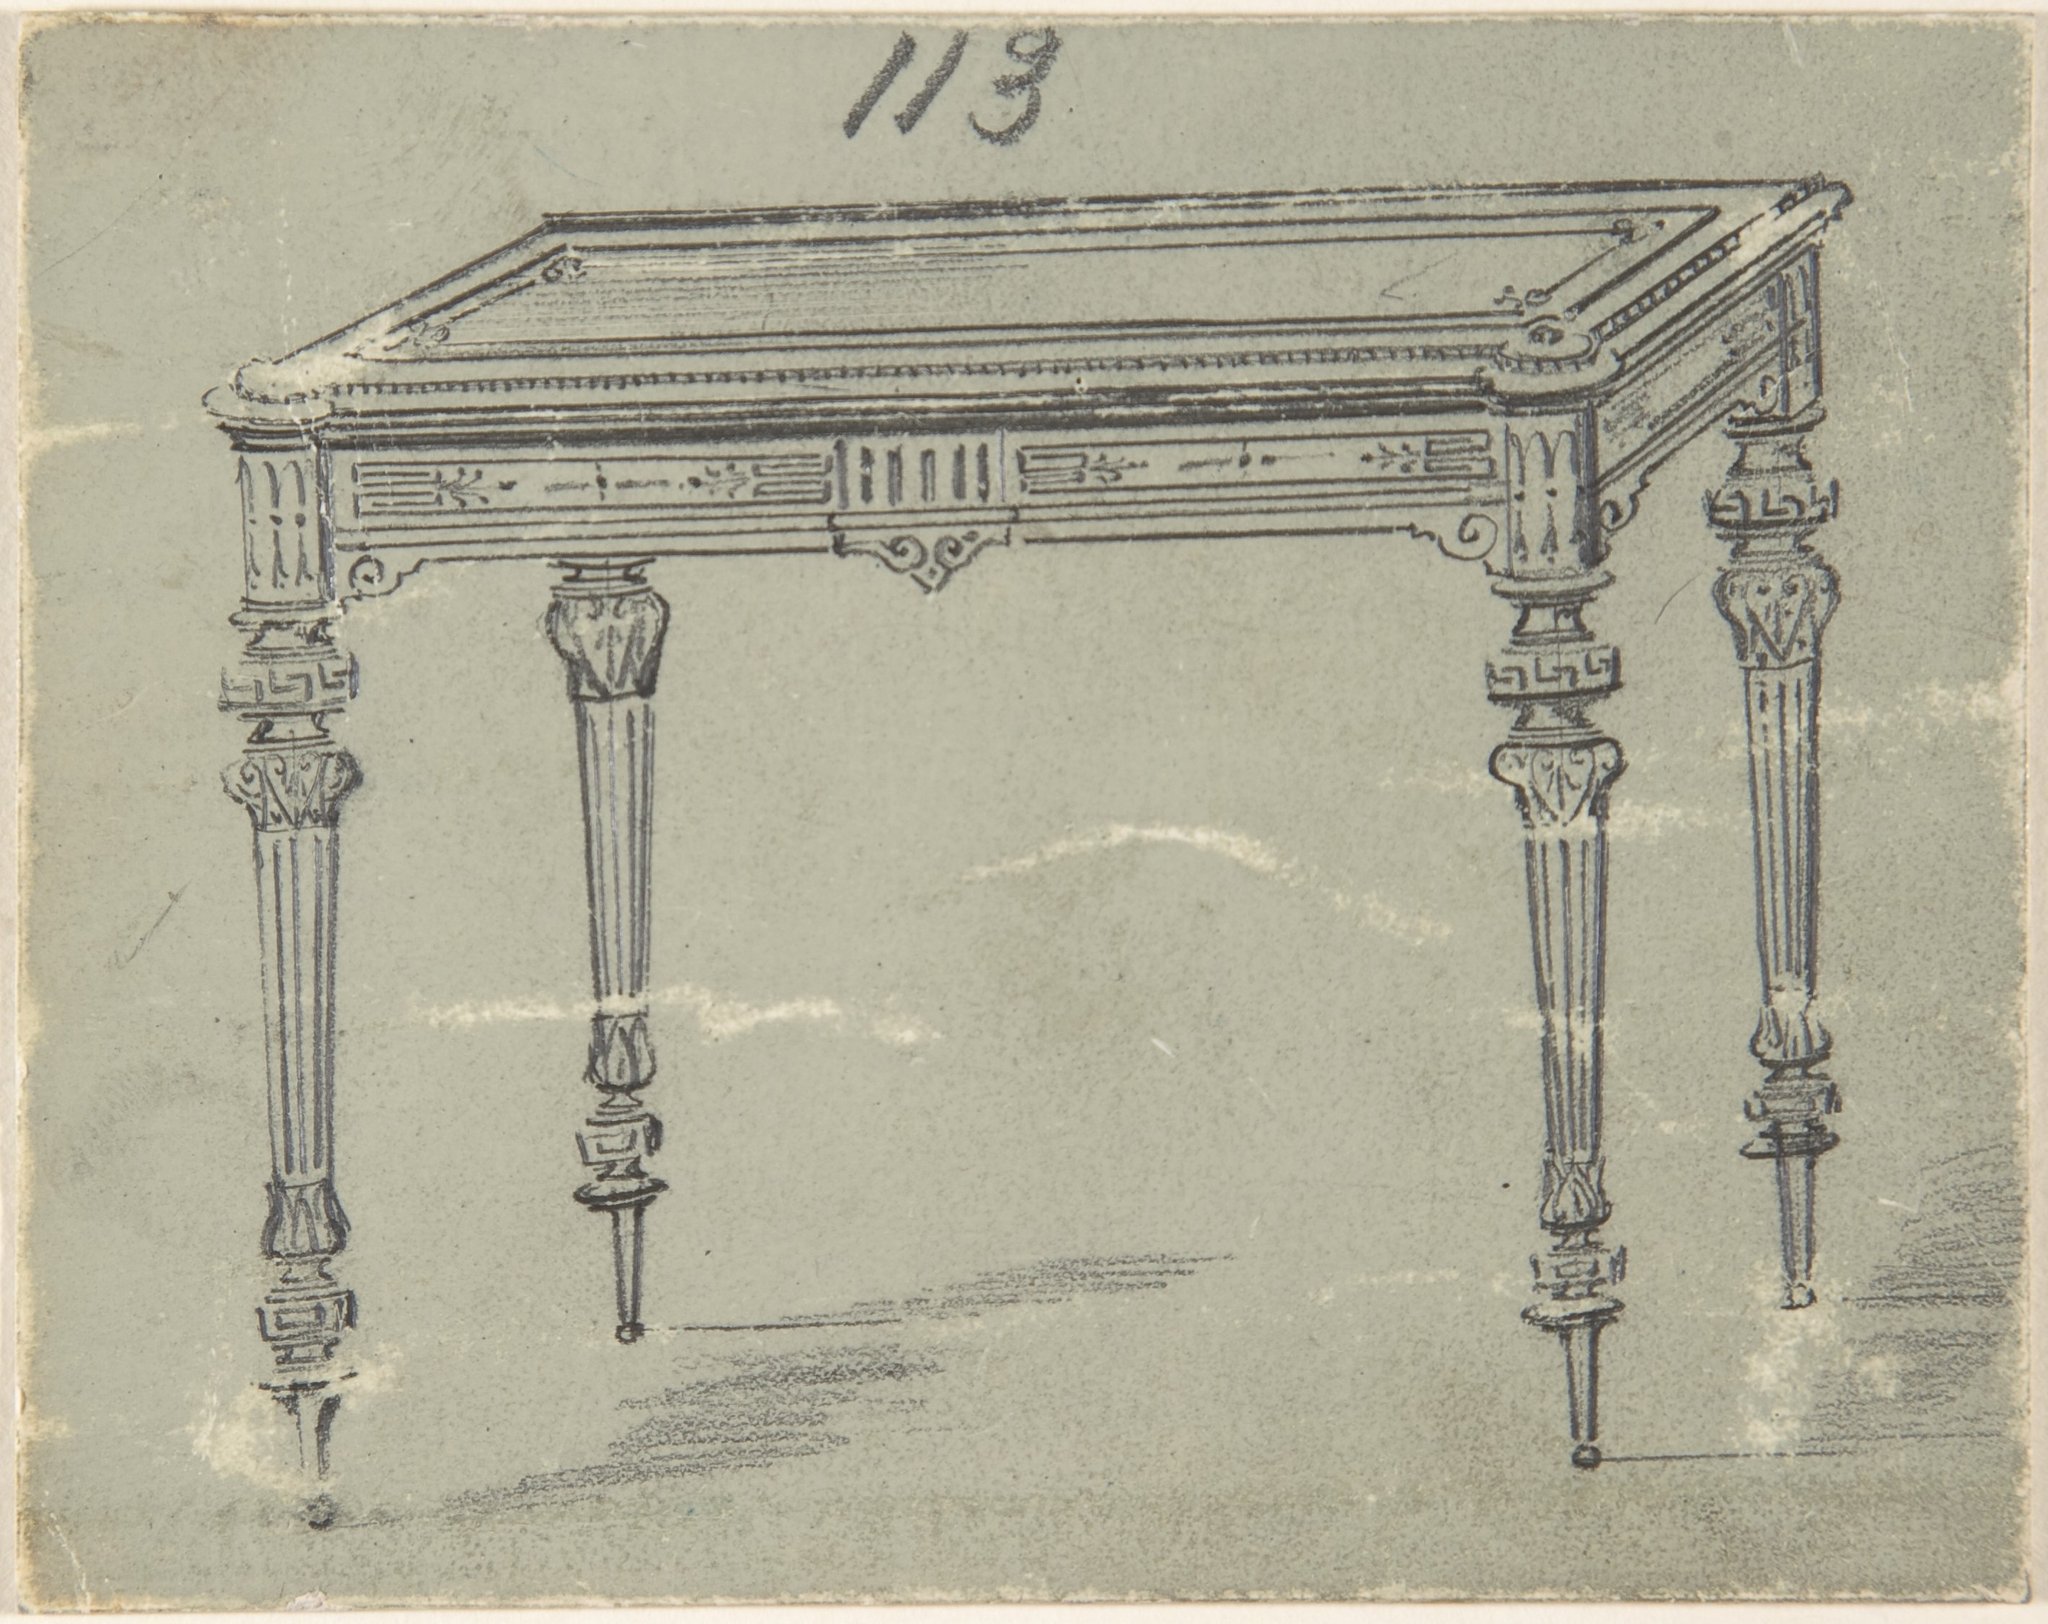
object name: drawing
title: Design for a Small Rectangular Table with Greek Ornament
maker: anonymous, british, 19th century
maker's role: artist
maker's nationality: british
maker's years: 1800-1900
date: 1801-1900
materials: graphite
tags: tables